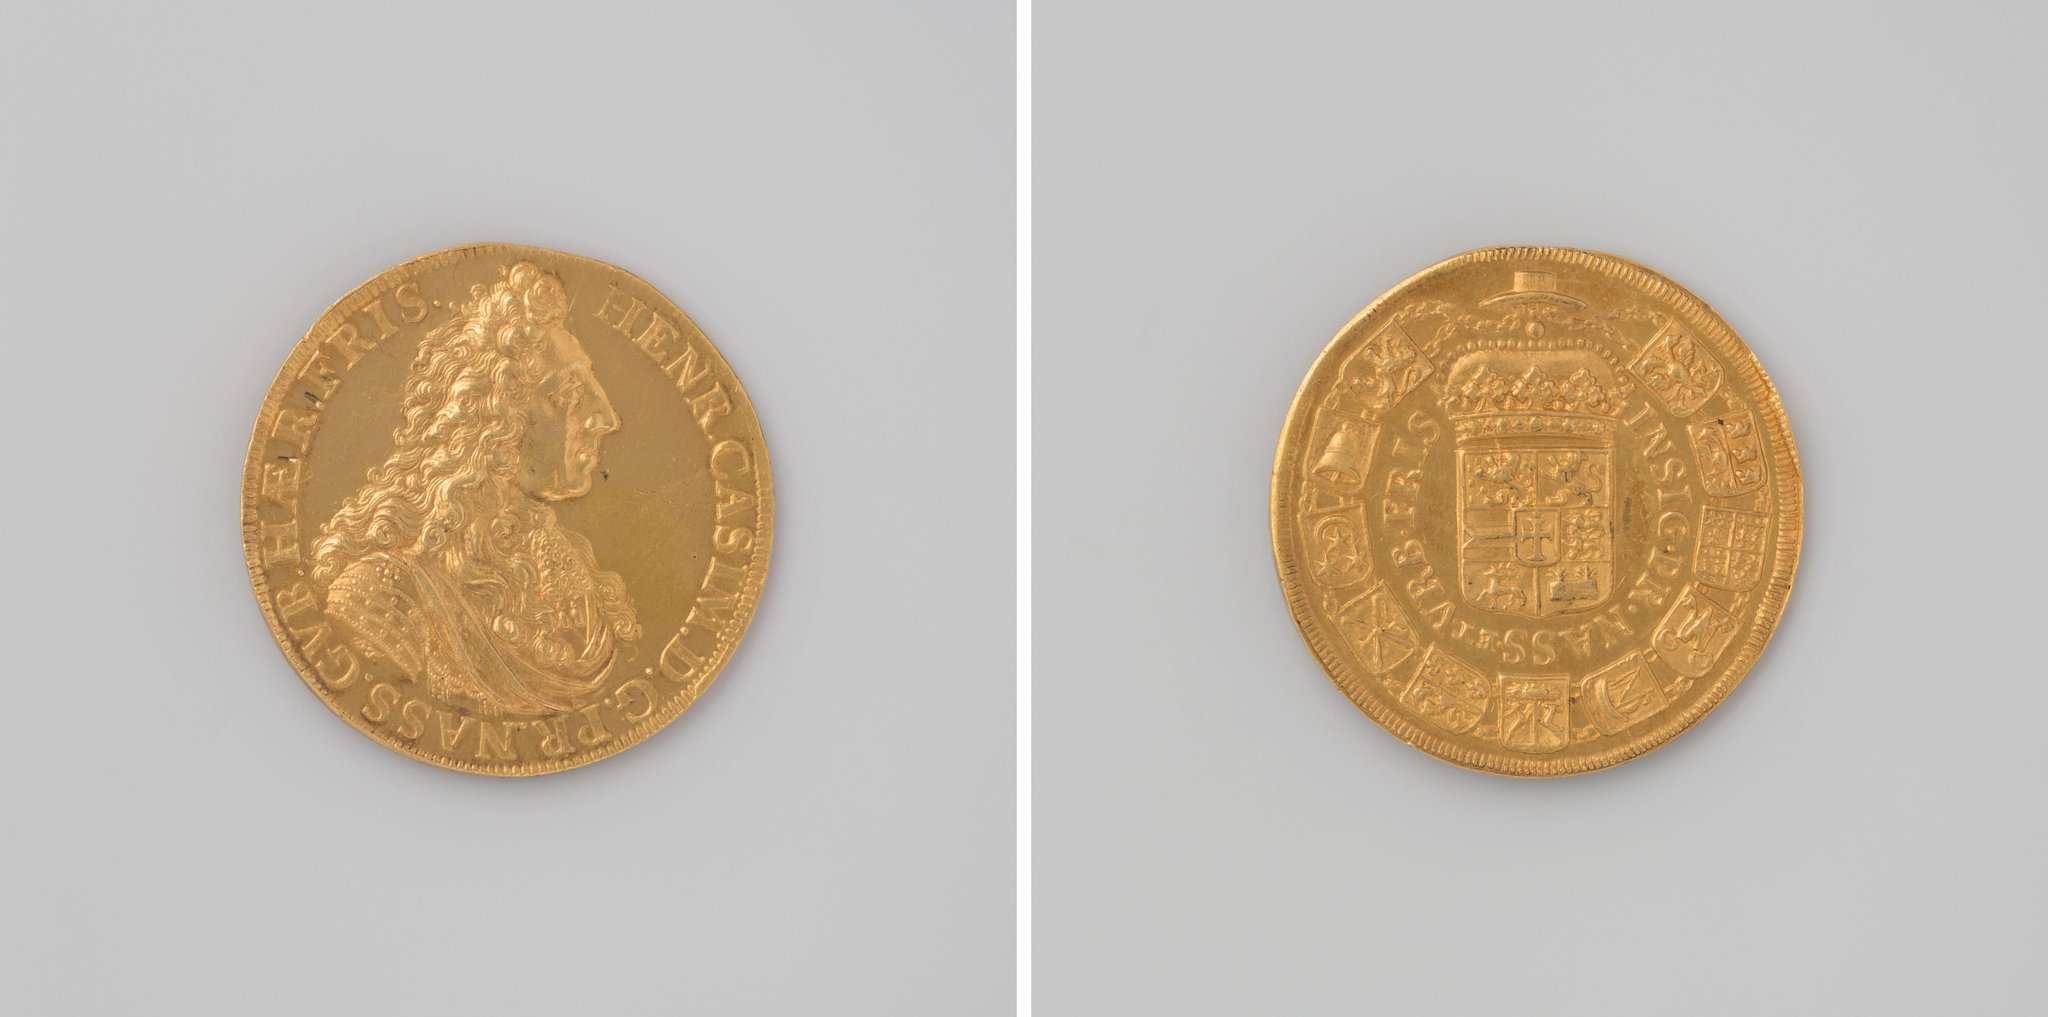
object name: medal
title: Hendrik Casimir II, stadhouder van Friesland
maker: daniel drappentier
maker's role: medailleur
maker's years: 1643-1714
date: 1696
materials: gold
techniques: striking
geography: dordrecht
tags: the hague, hendrik casimir ii graaf van nassau-dietz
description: Gouden penning. Voorzijde: borststuk man binnen omschrift. Keerzijde: gekroond wapenschild onder vrijheidshoed binnen omschrift en rand van elf wapenschilden